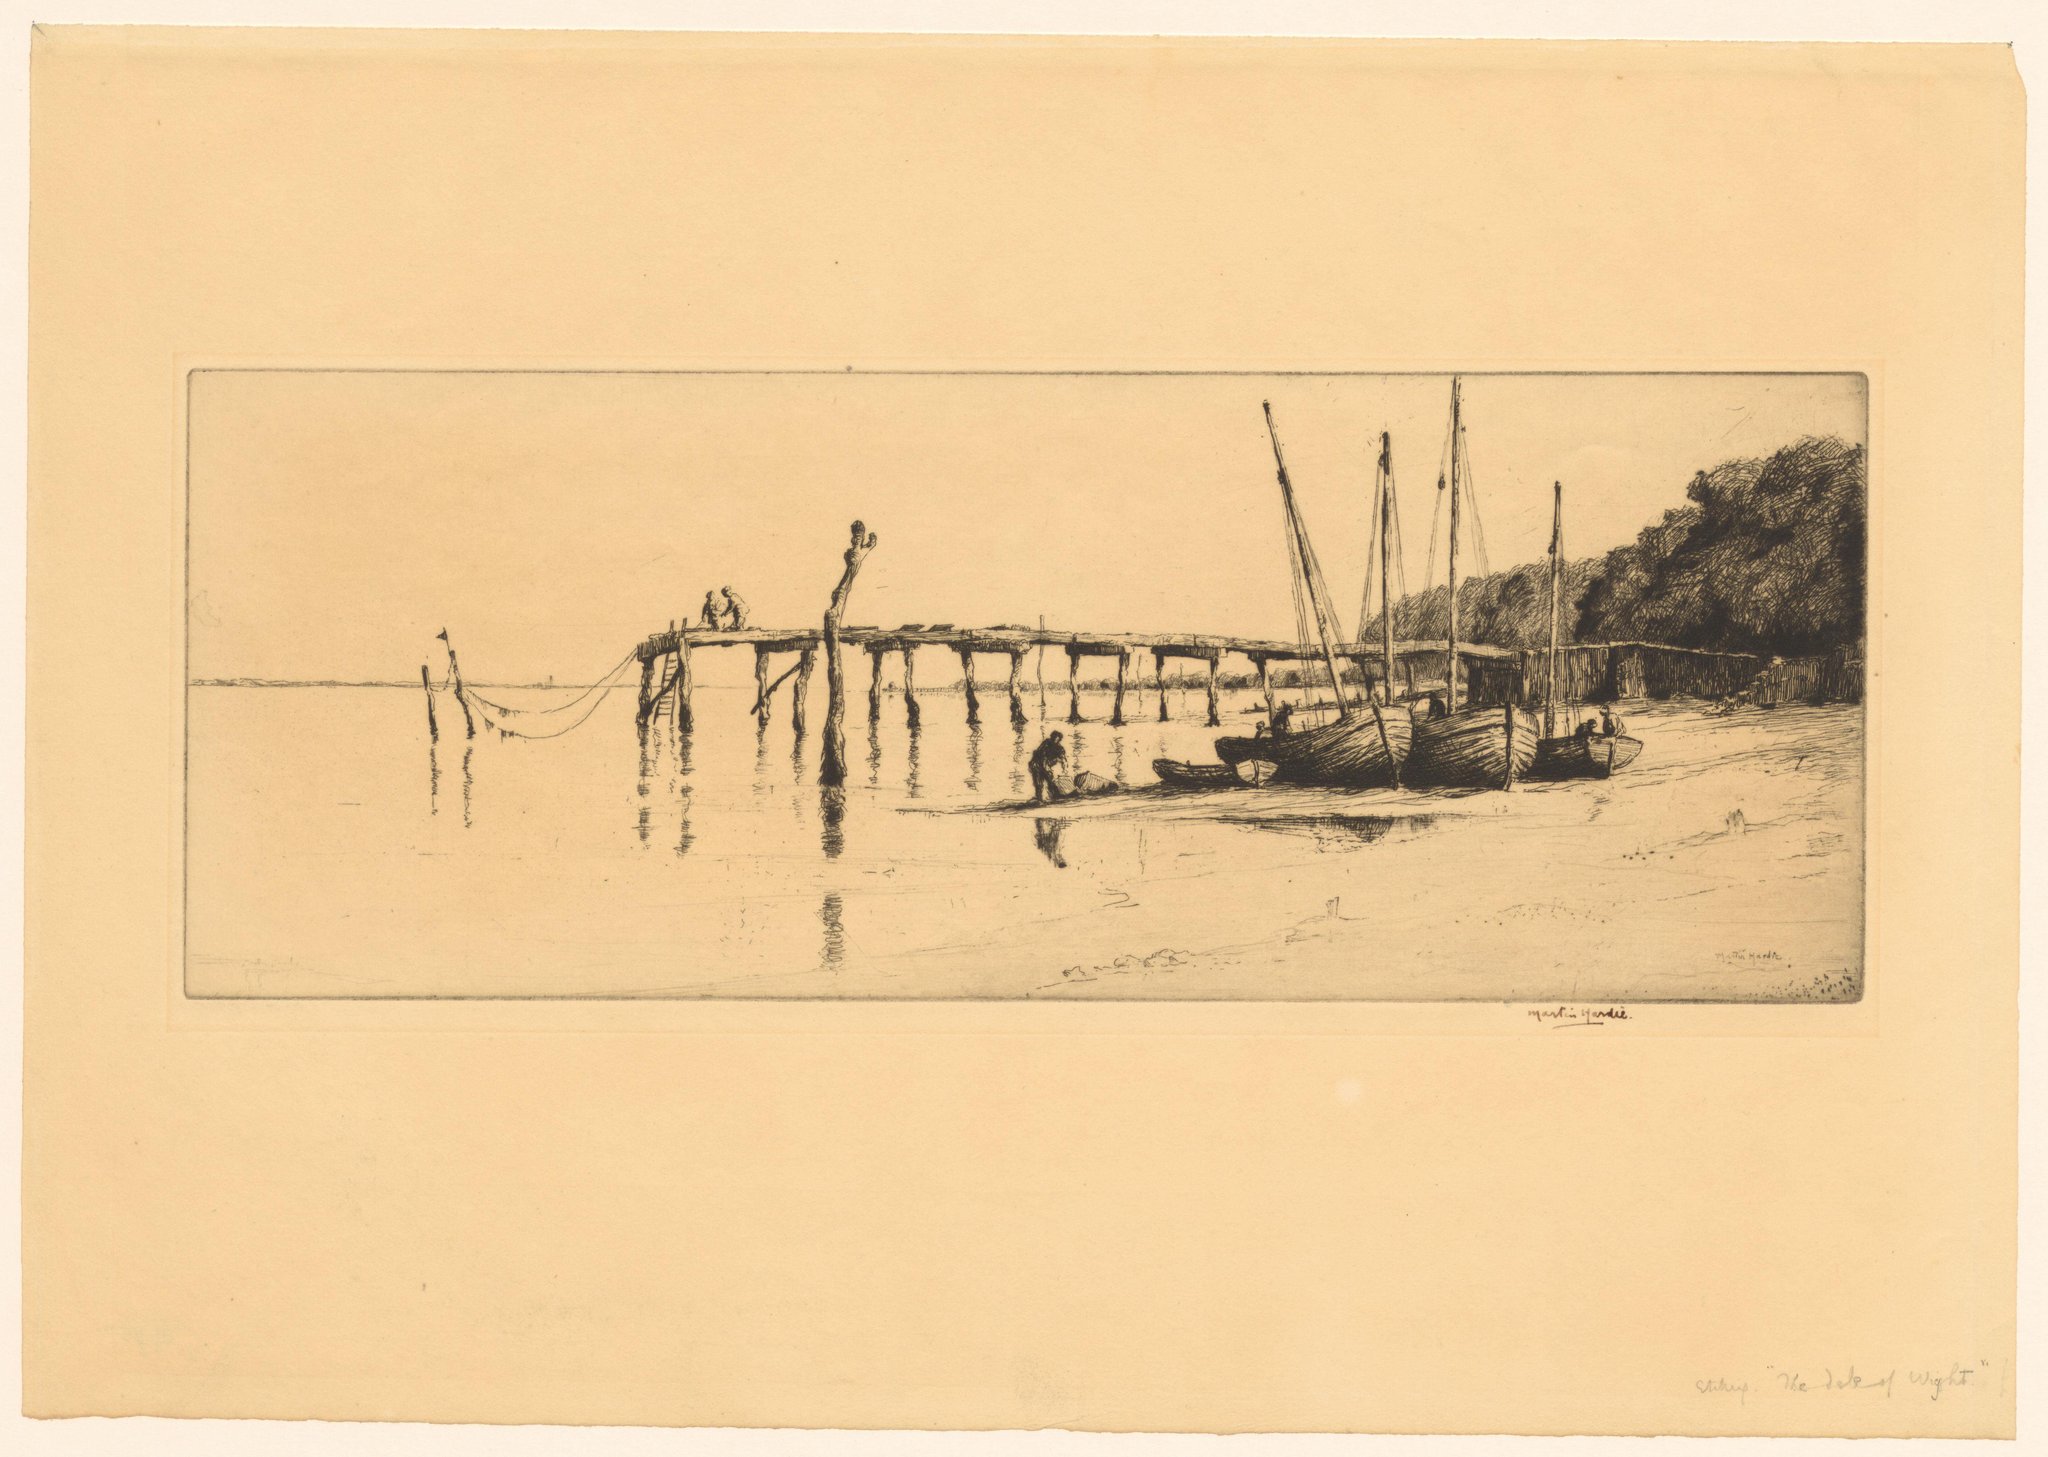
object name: print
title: Gezicht op de kust van Isle of Wight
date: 1919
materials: paper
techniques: drypoint, etching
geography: isle of wight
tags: coast, isle of wight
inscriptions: collector's mark: Lugt 2228